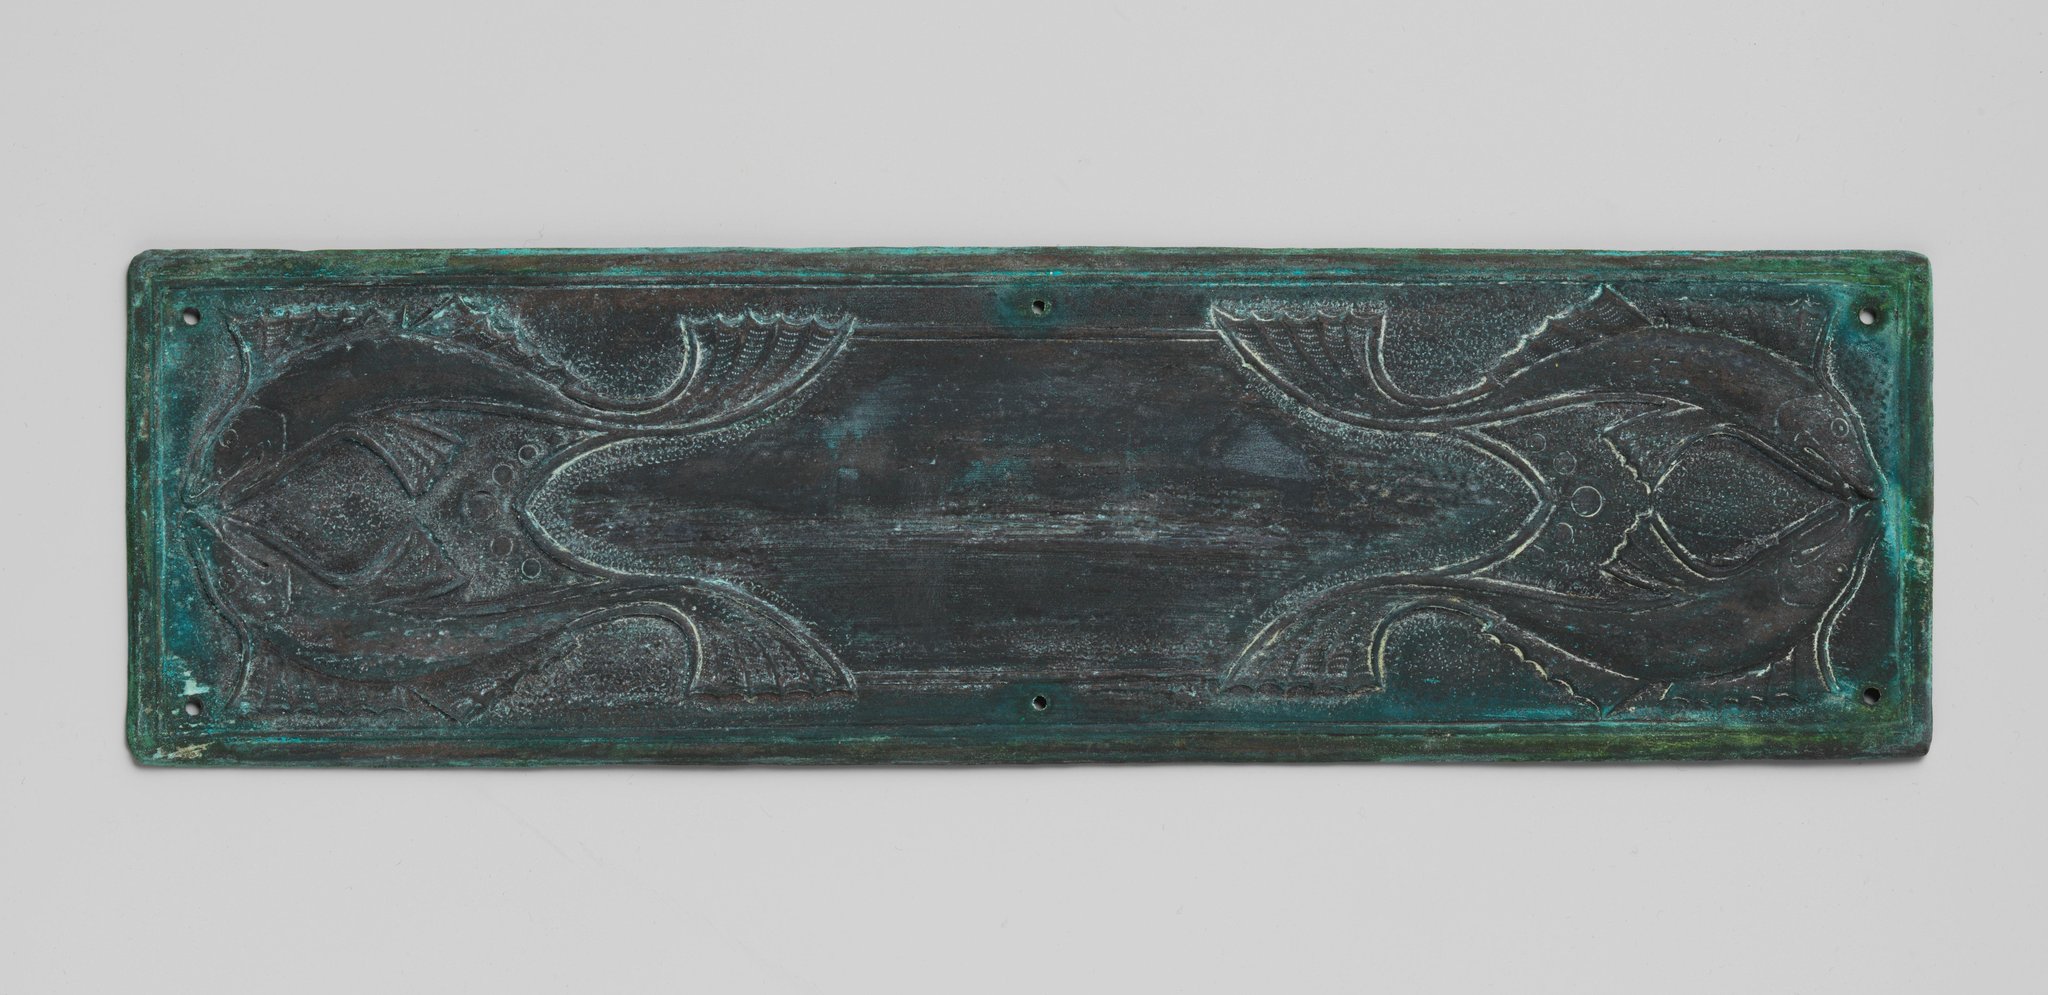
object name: push plate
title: Deurplaat met vissen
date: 1910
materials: copper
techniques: punching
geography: hengelo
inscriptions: factory mark, factory mark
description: De gedreven plaat vertoont boven- en onderaan een gedreven gestileerd ornament van twee antithetisch geplaatste vissen. Het oppervlak van deze versiering is met verschillende ponsstempels genuanceerd bewerkt.